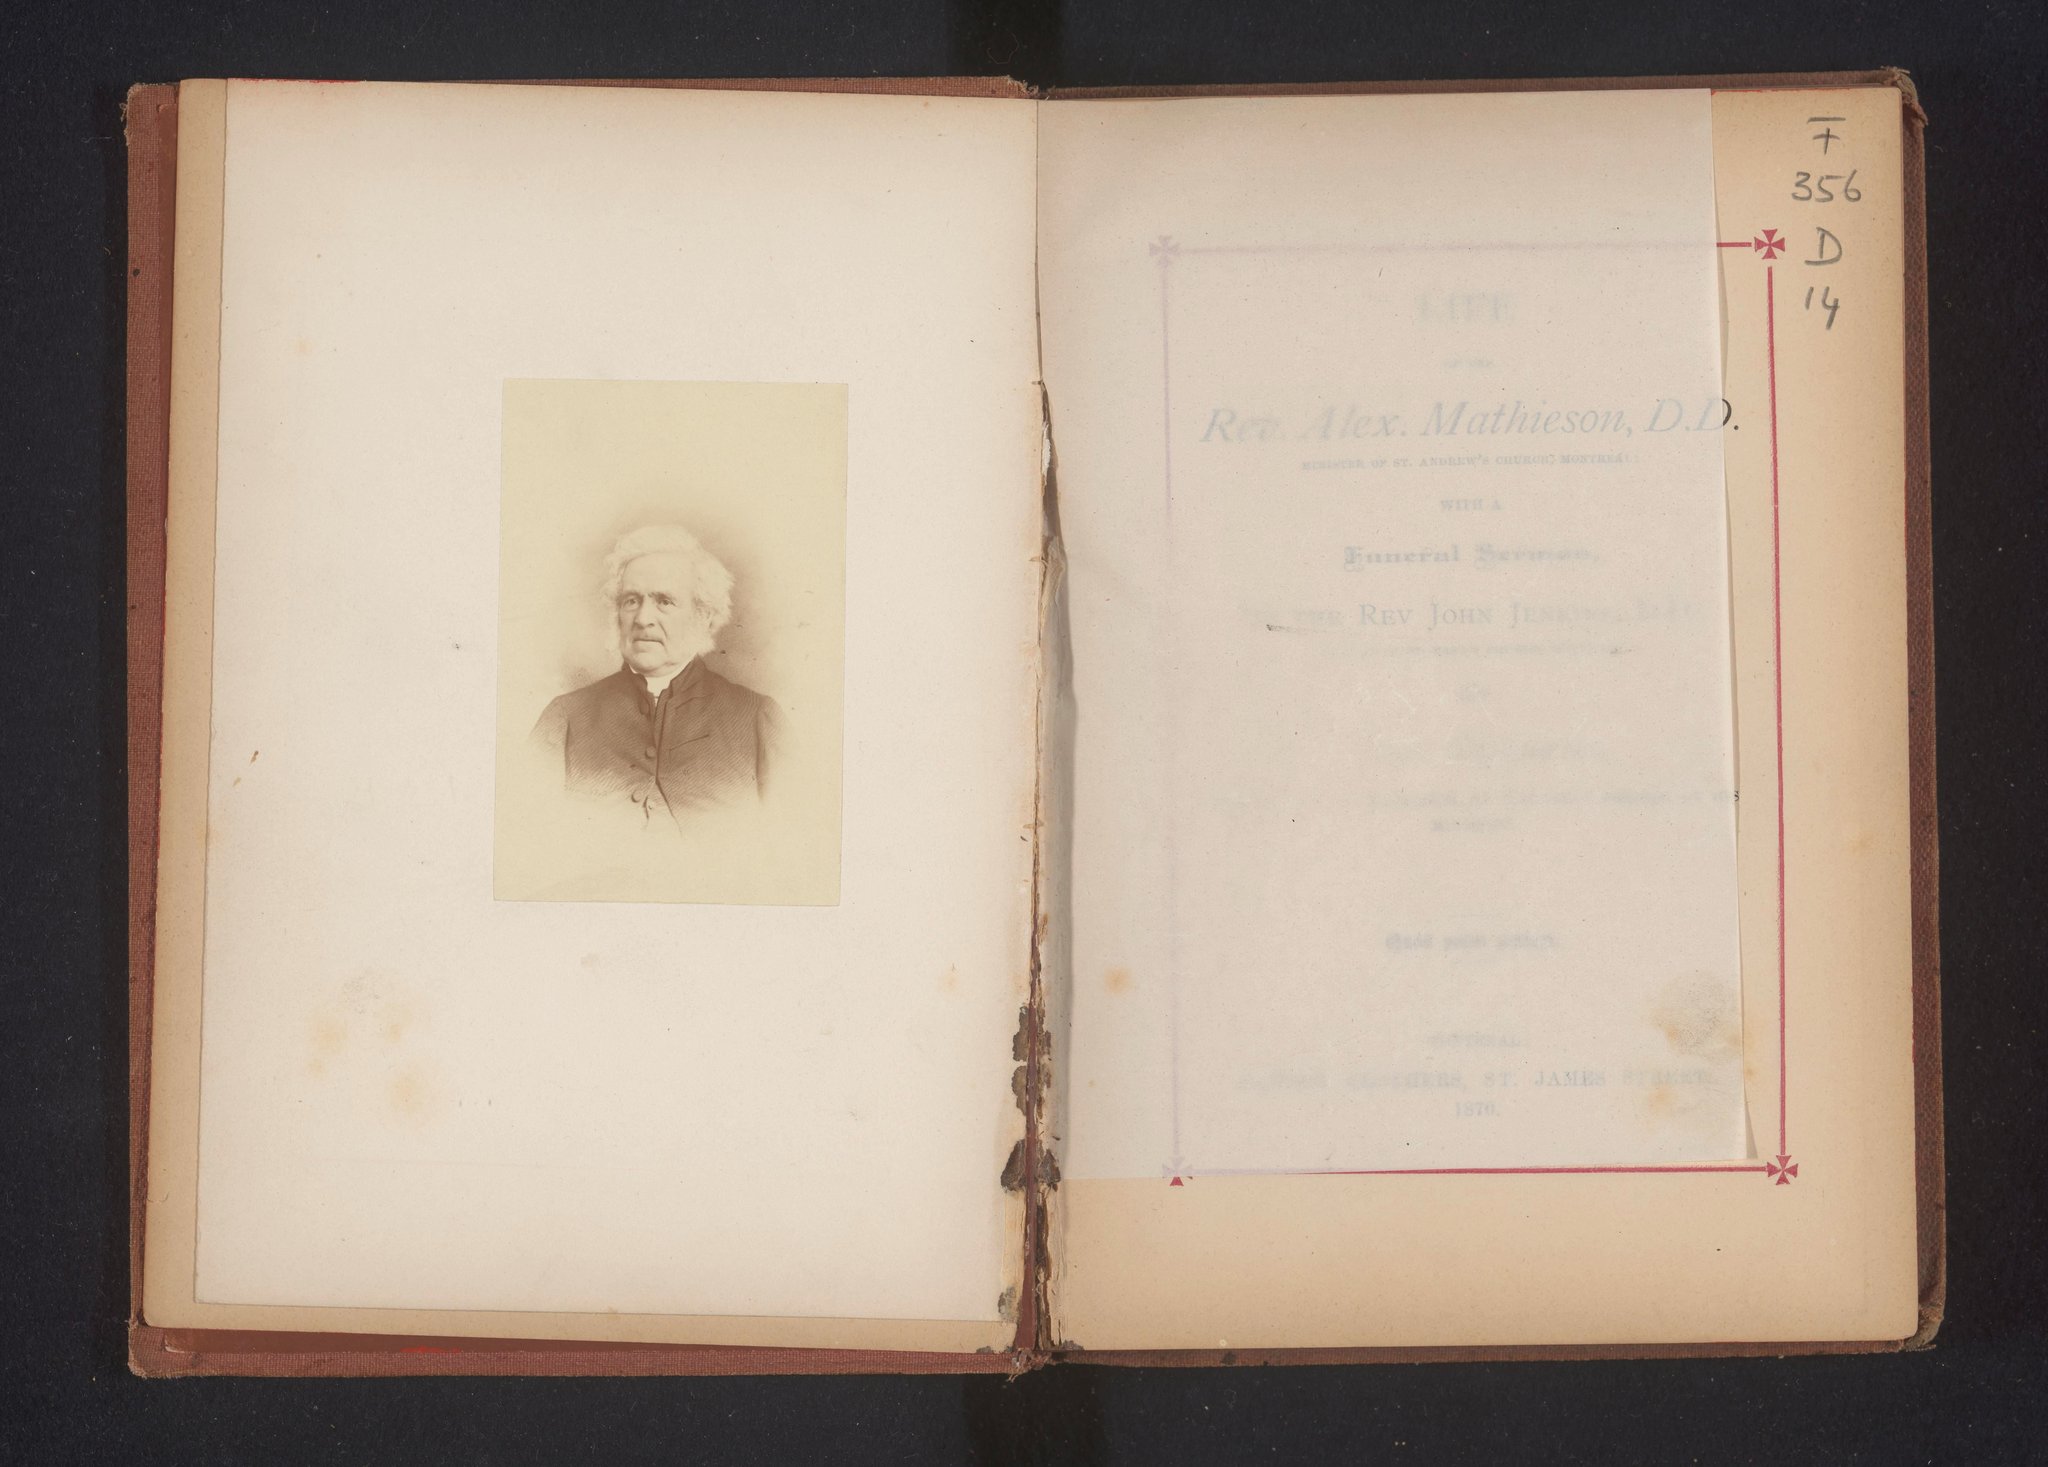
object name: page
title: Portret van Alexander Mathieson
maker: Anonymous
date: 1865-1870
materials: photographic support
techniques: albumen print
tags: alexander mathieson, functionaries and dignitaries ~ protestant churches